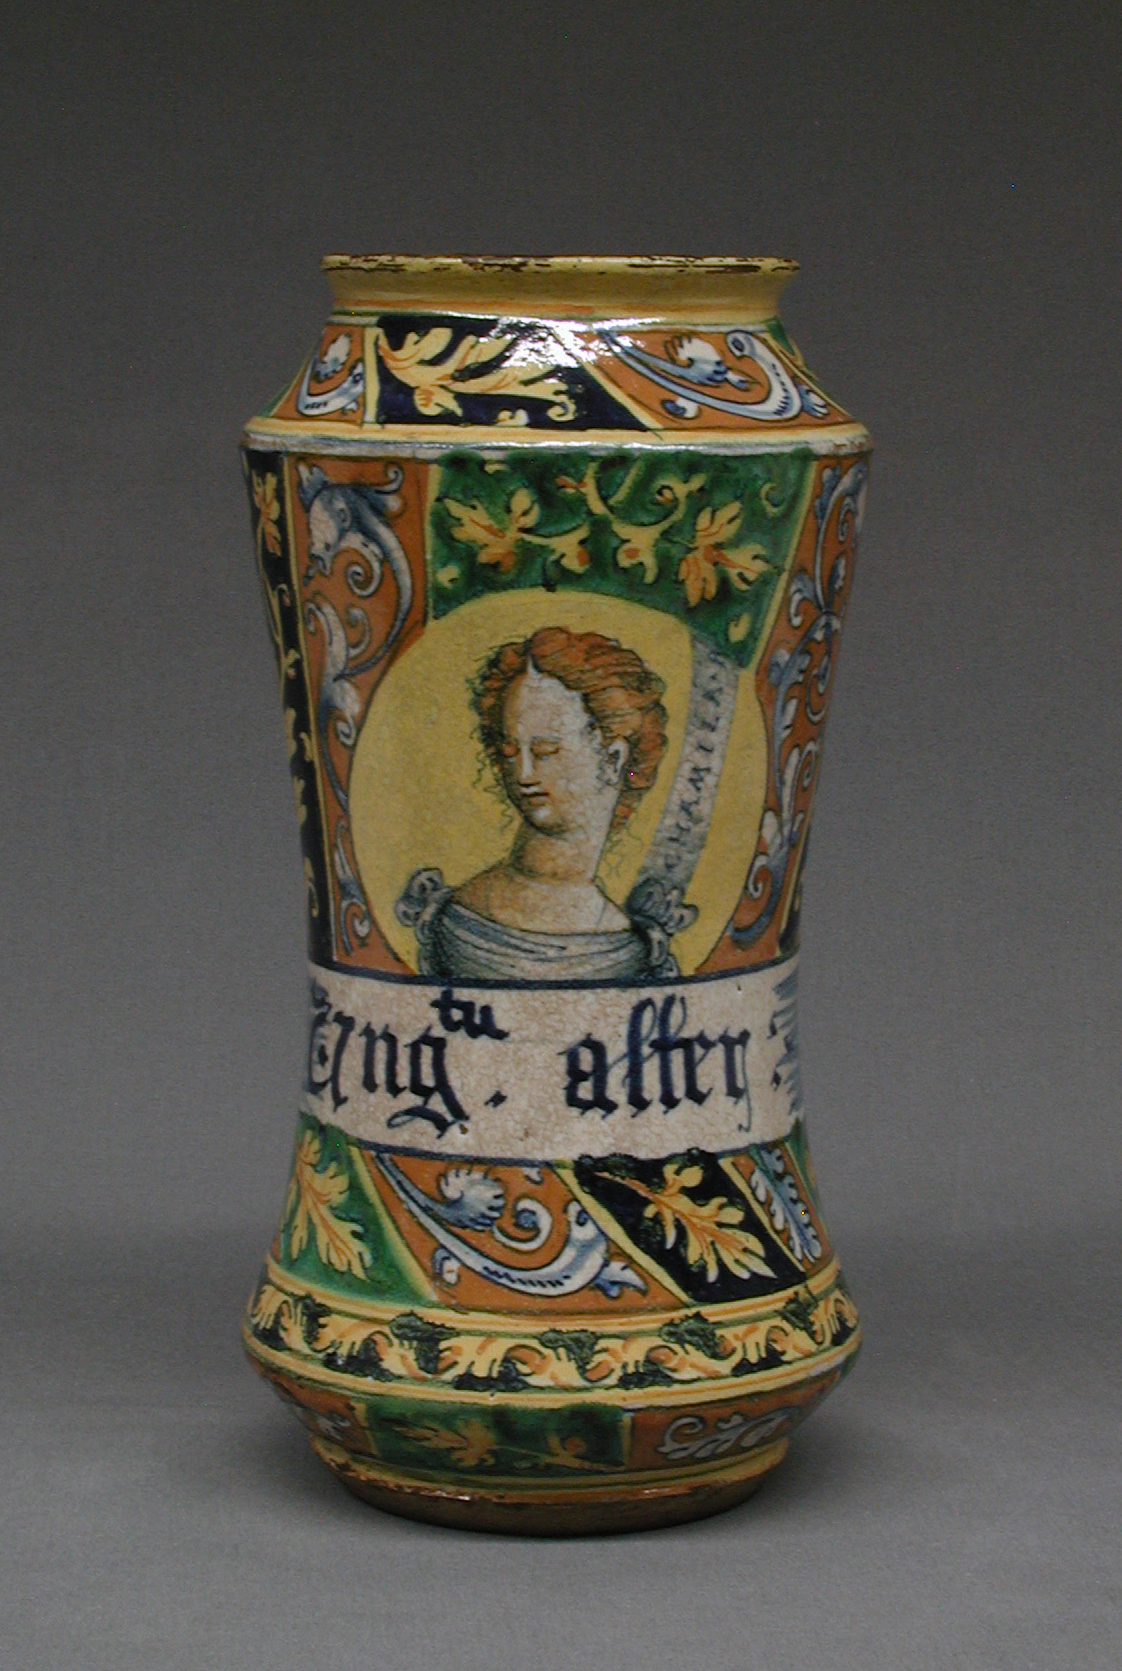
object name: pharmacy jar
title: Pharmacy jar (albarello)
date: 1540-1550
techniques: maiolica, glazing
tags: women